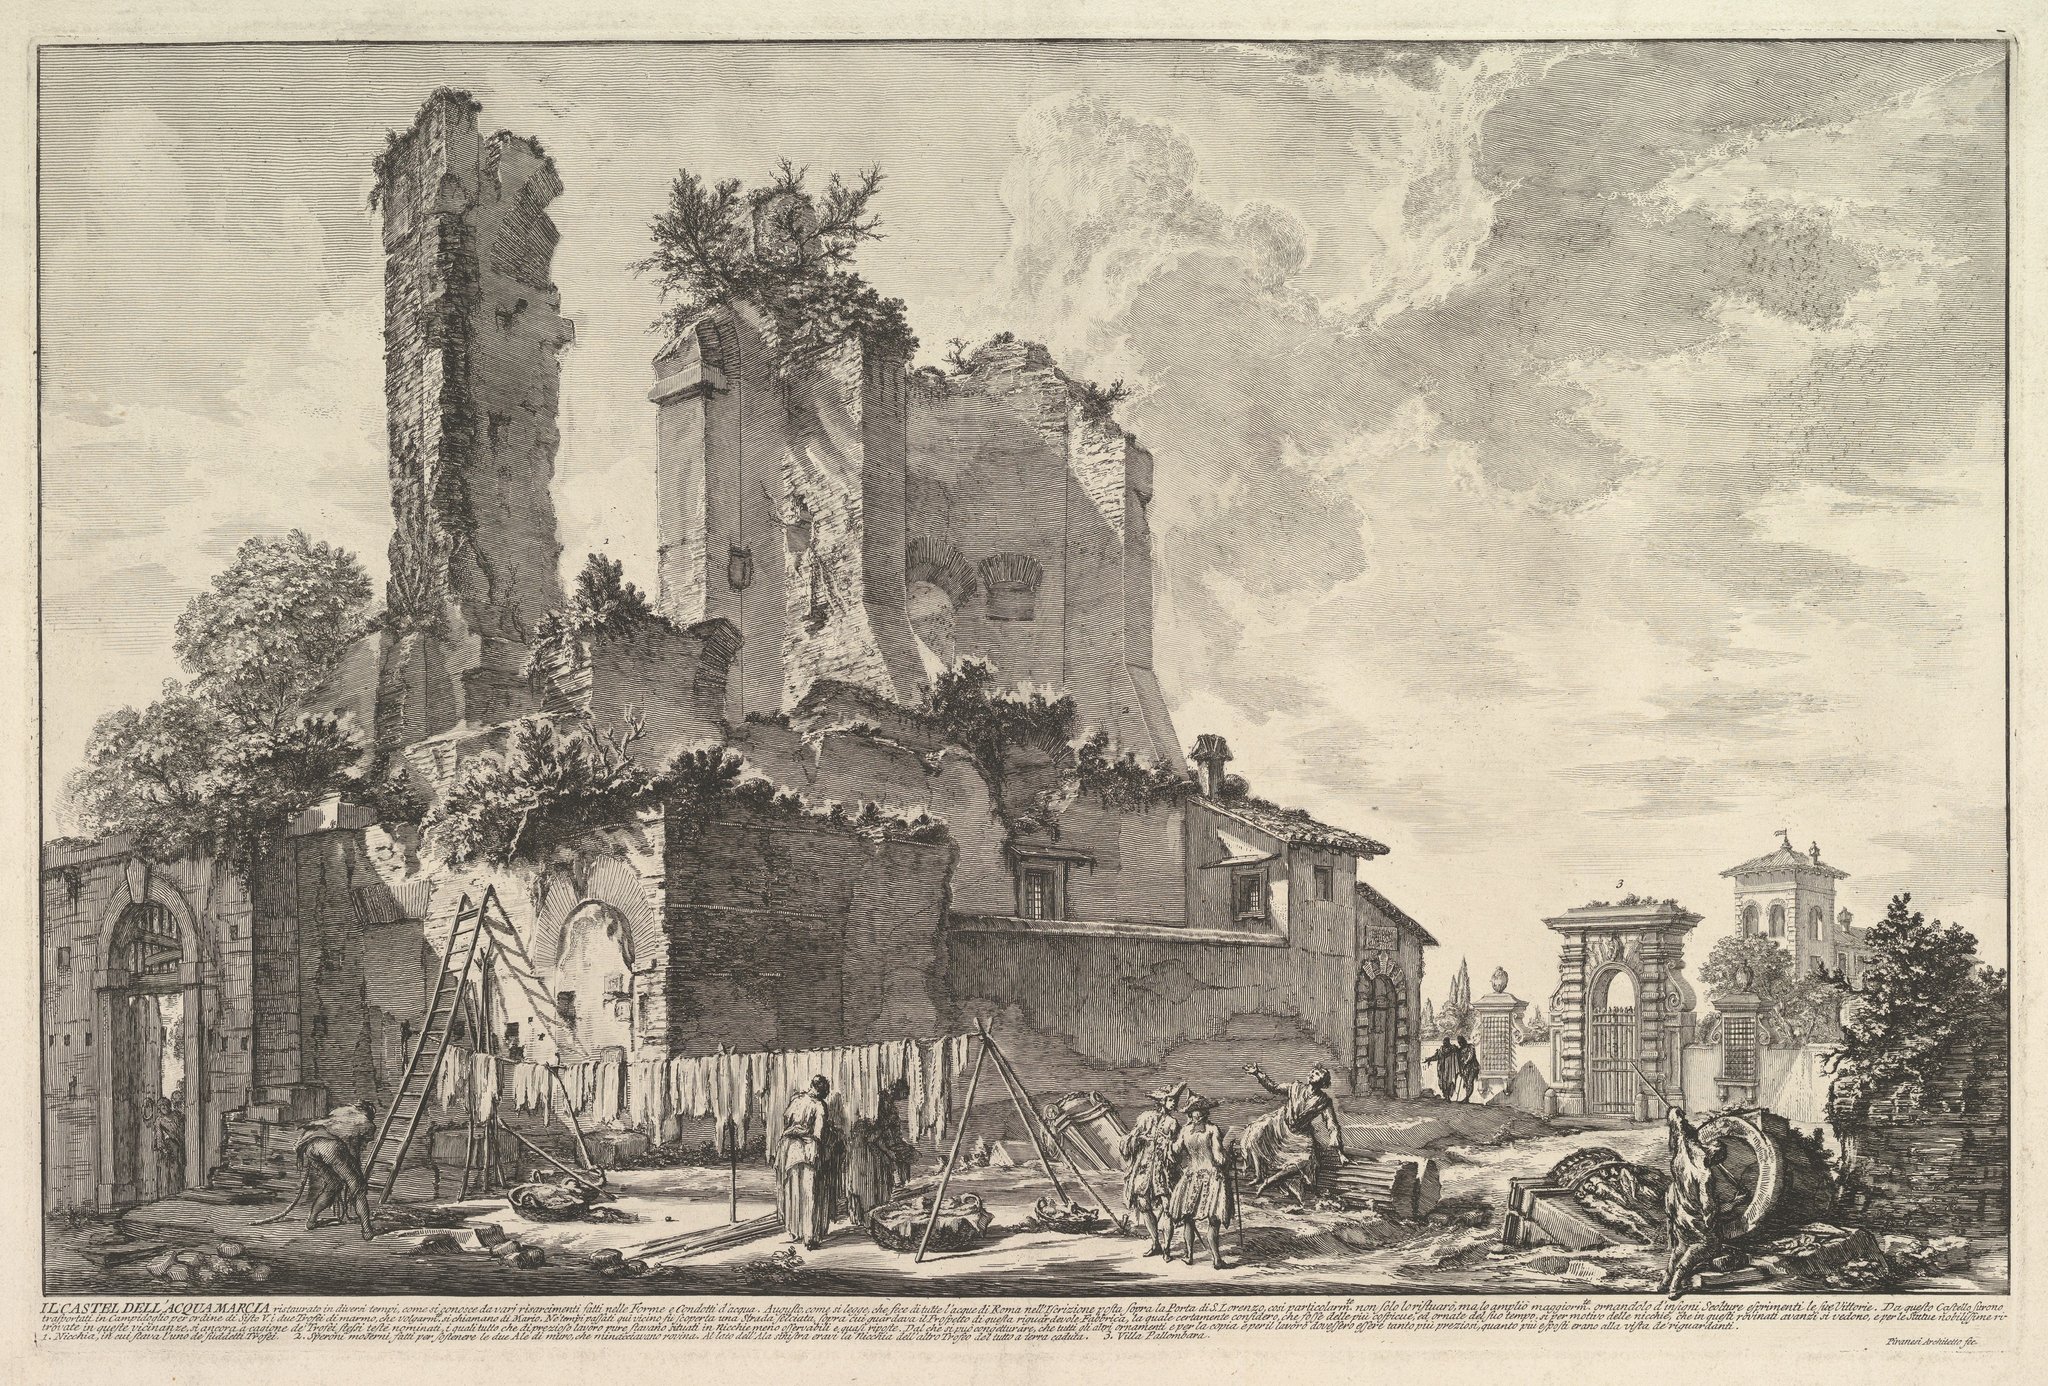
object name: print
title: The Fontana dell'Aqua Giulia (Vedute dell avanzo del Castello del'Aqua Giulia)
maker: giovanni battista piranesi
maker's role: artist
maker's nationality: italian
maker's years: 1720-1778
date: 1753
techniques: etching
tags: human figures,castles,ruins